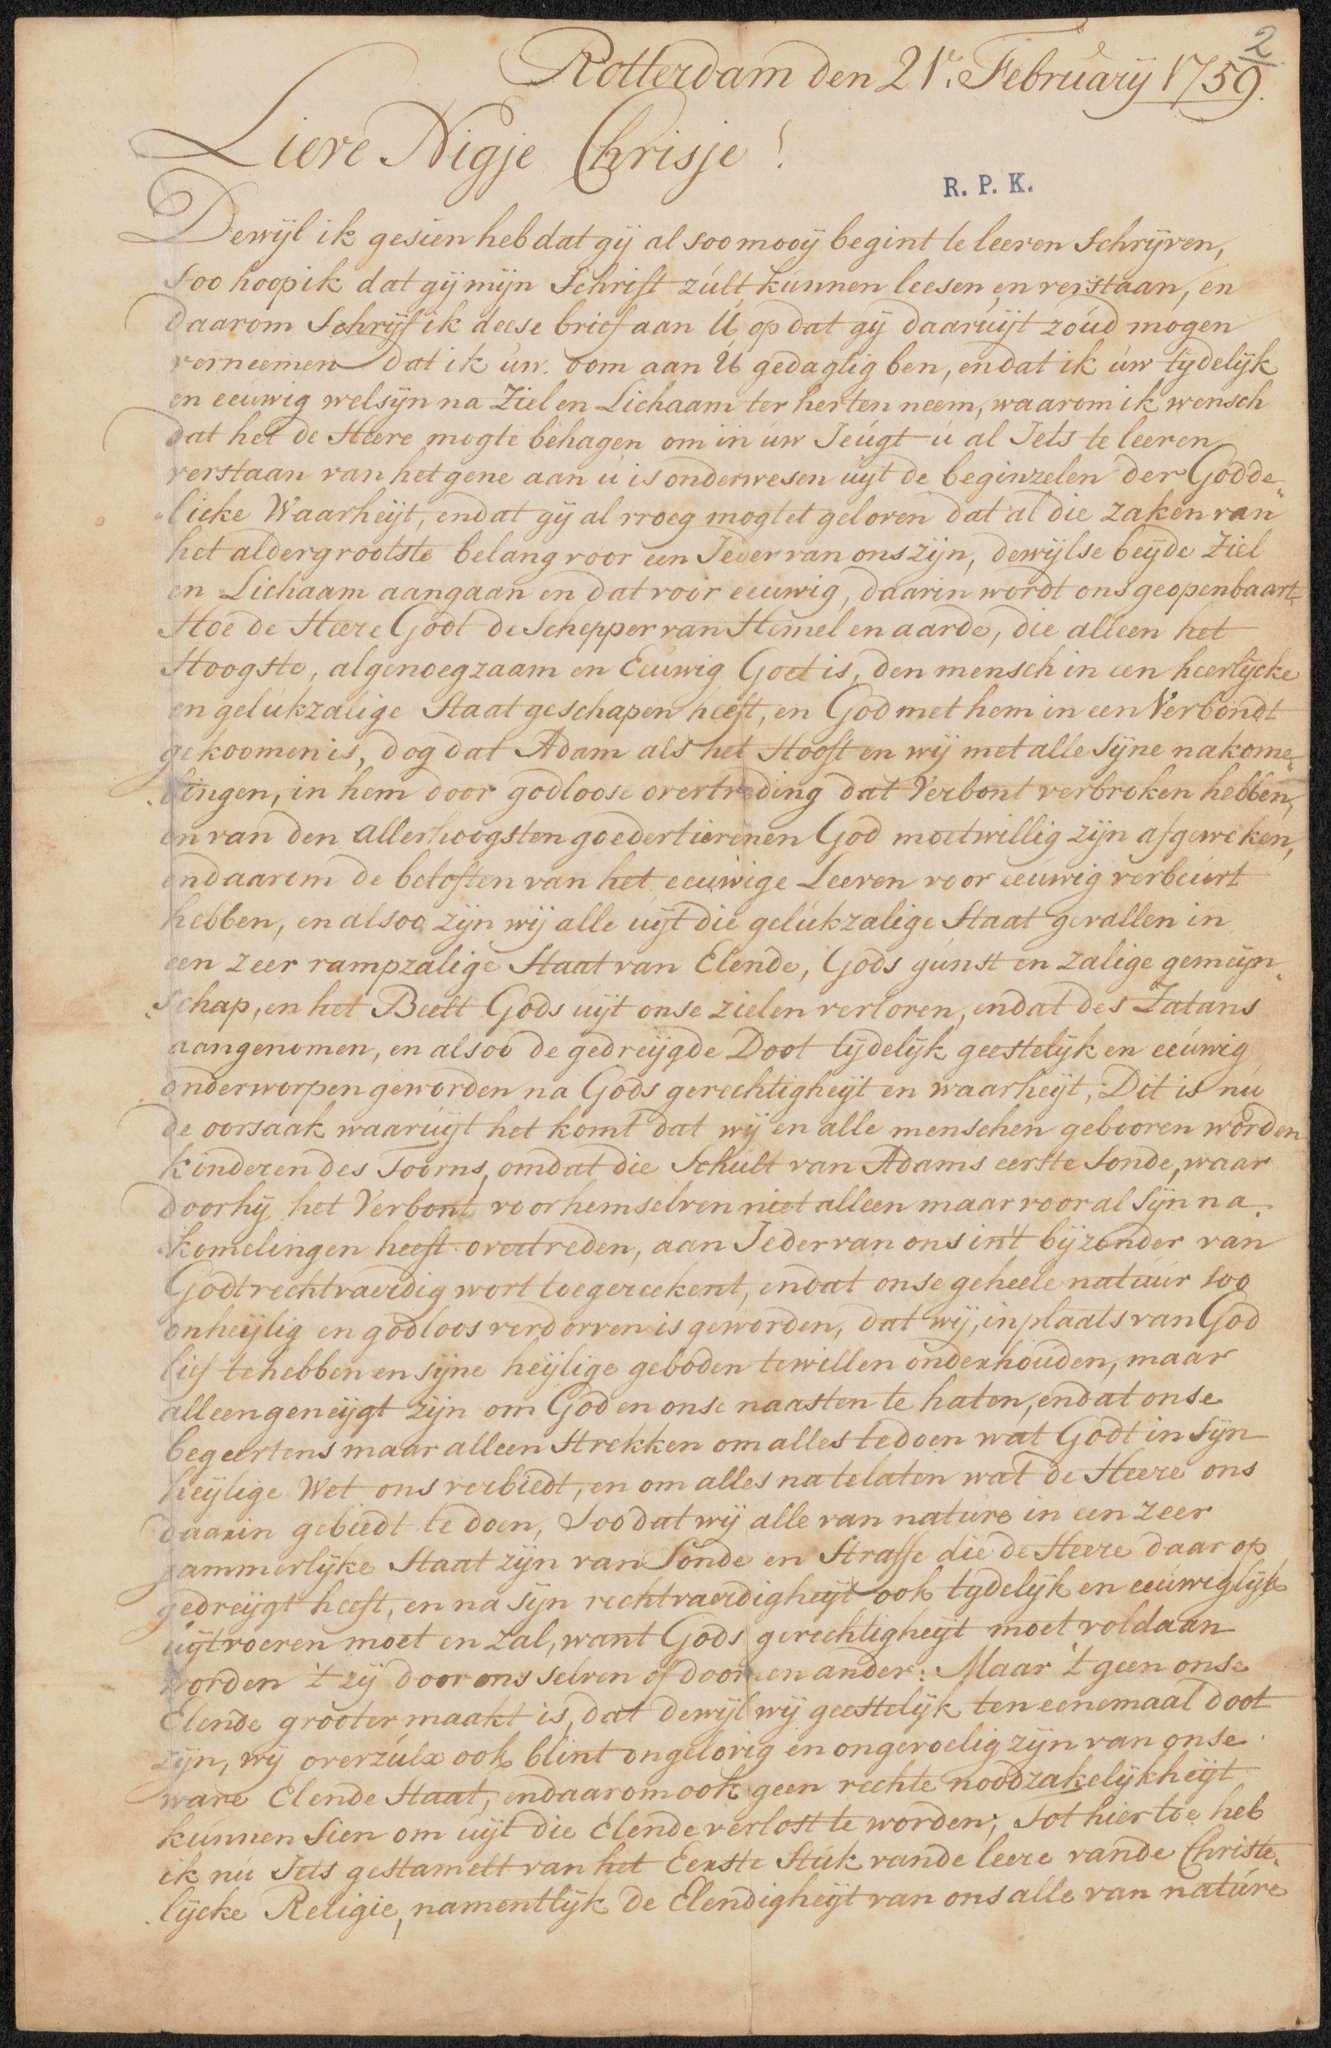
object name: letter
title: Brief aan Christina Sibilla Charlotte Bakhuizen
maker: gerrit backhuijzen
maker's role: draughtsman, painter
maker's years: 1721-1760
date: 1759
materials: ink, paper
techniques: pen, writing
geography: rotterdam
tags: christina sibilla charlotta bakhuizen, christian religion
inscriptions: collector's mark: Lugt 2233, watermark